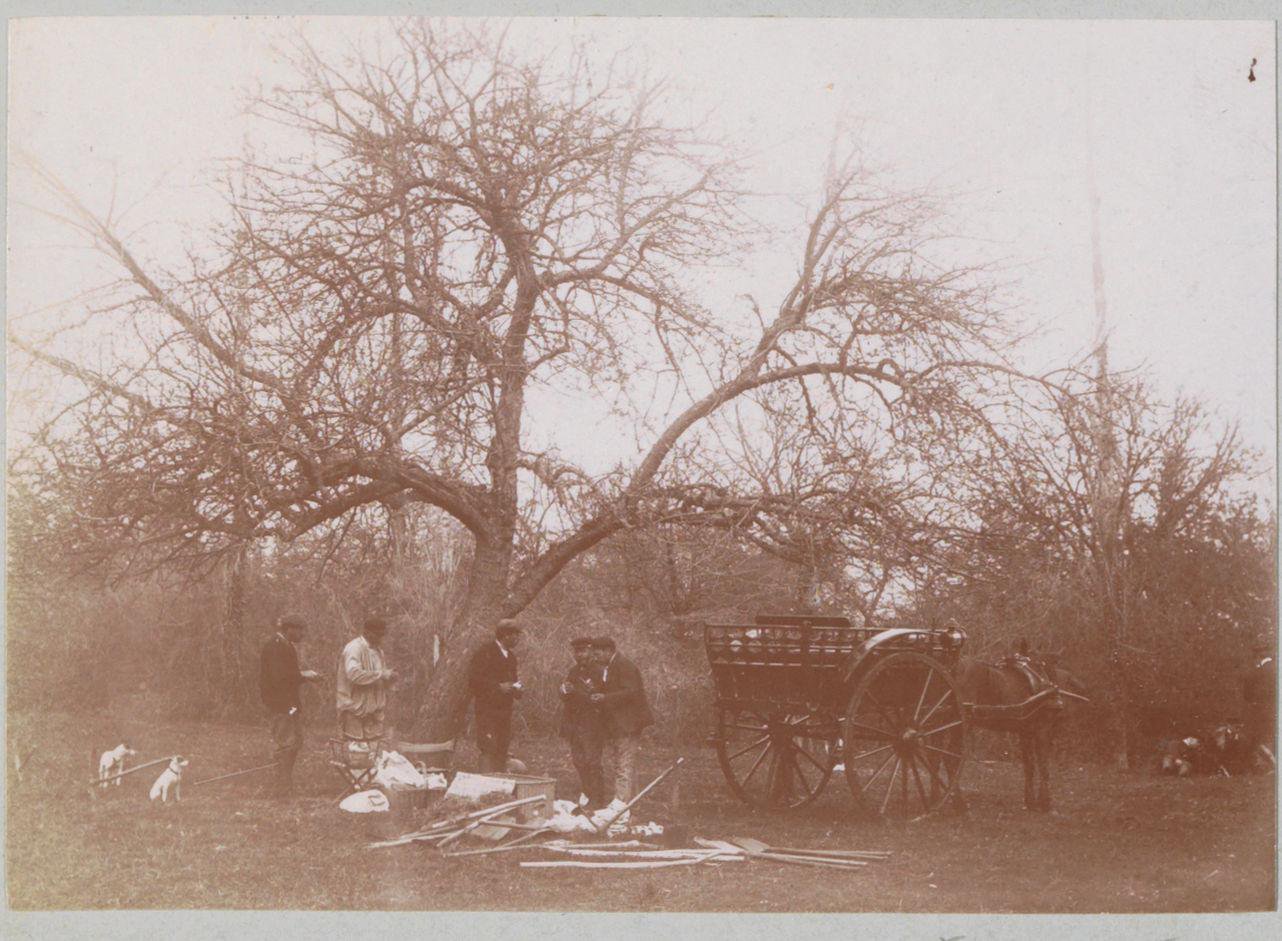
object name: photograph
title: Mannen met een kar onder een boom, vermoedelijk tijdens het oogsten in Midden-Frankrijk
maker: delizy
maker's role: manufacturer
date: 1899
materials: paper, photographic support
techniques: gelatin silver print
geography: france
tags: harvest, two-wheeled, animal-drawn vehicle, france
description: Onderdeel van Fotoalbum van een Franse amateurfotograaf met opnames van uitstapjes in Frankrijk, Spanje, België, Luxemburg en Nederland, de eerste automobielen en autoraces.